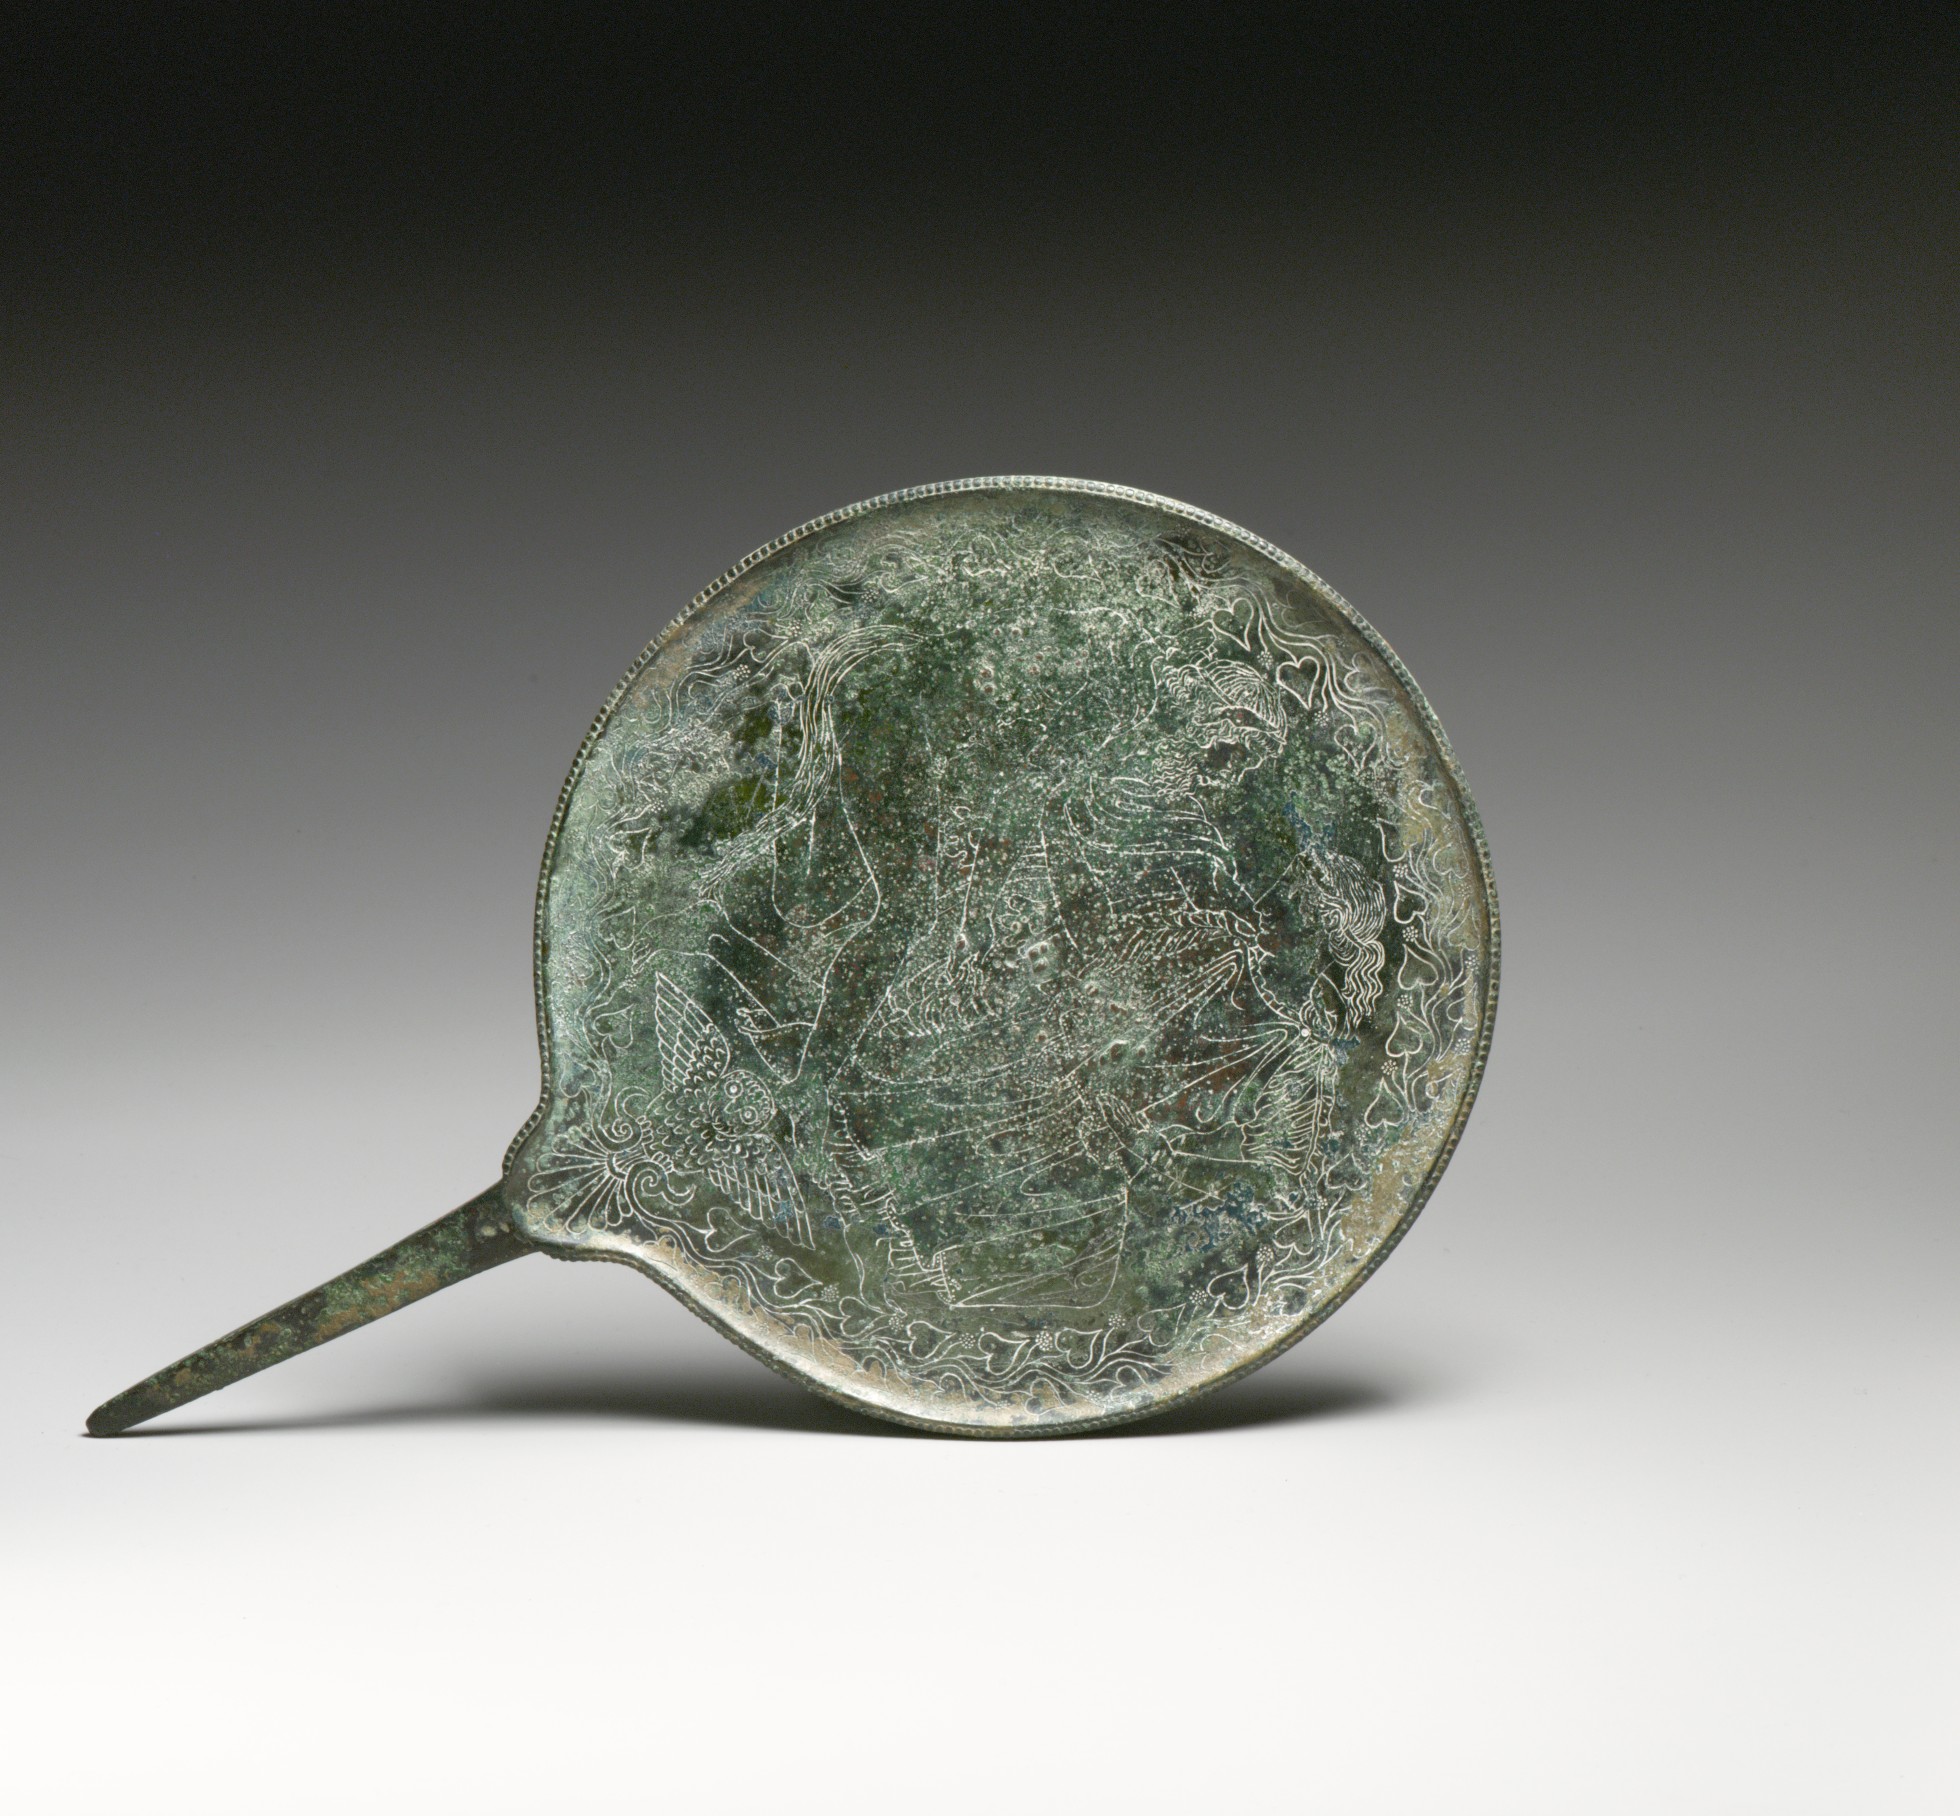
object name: mirror with satyr and nymph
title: Bronze mirror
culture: etruscan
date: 425-400 BCE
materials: bronze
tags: maenads,satyrs